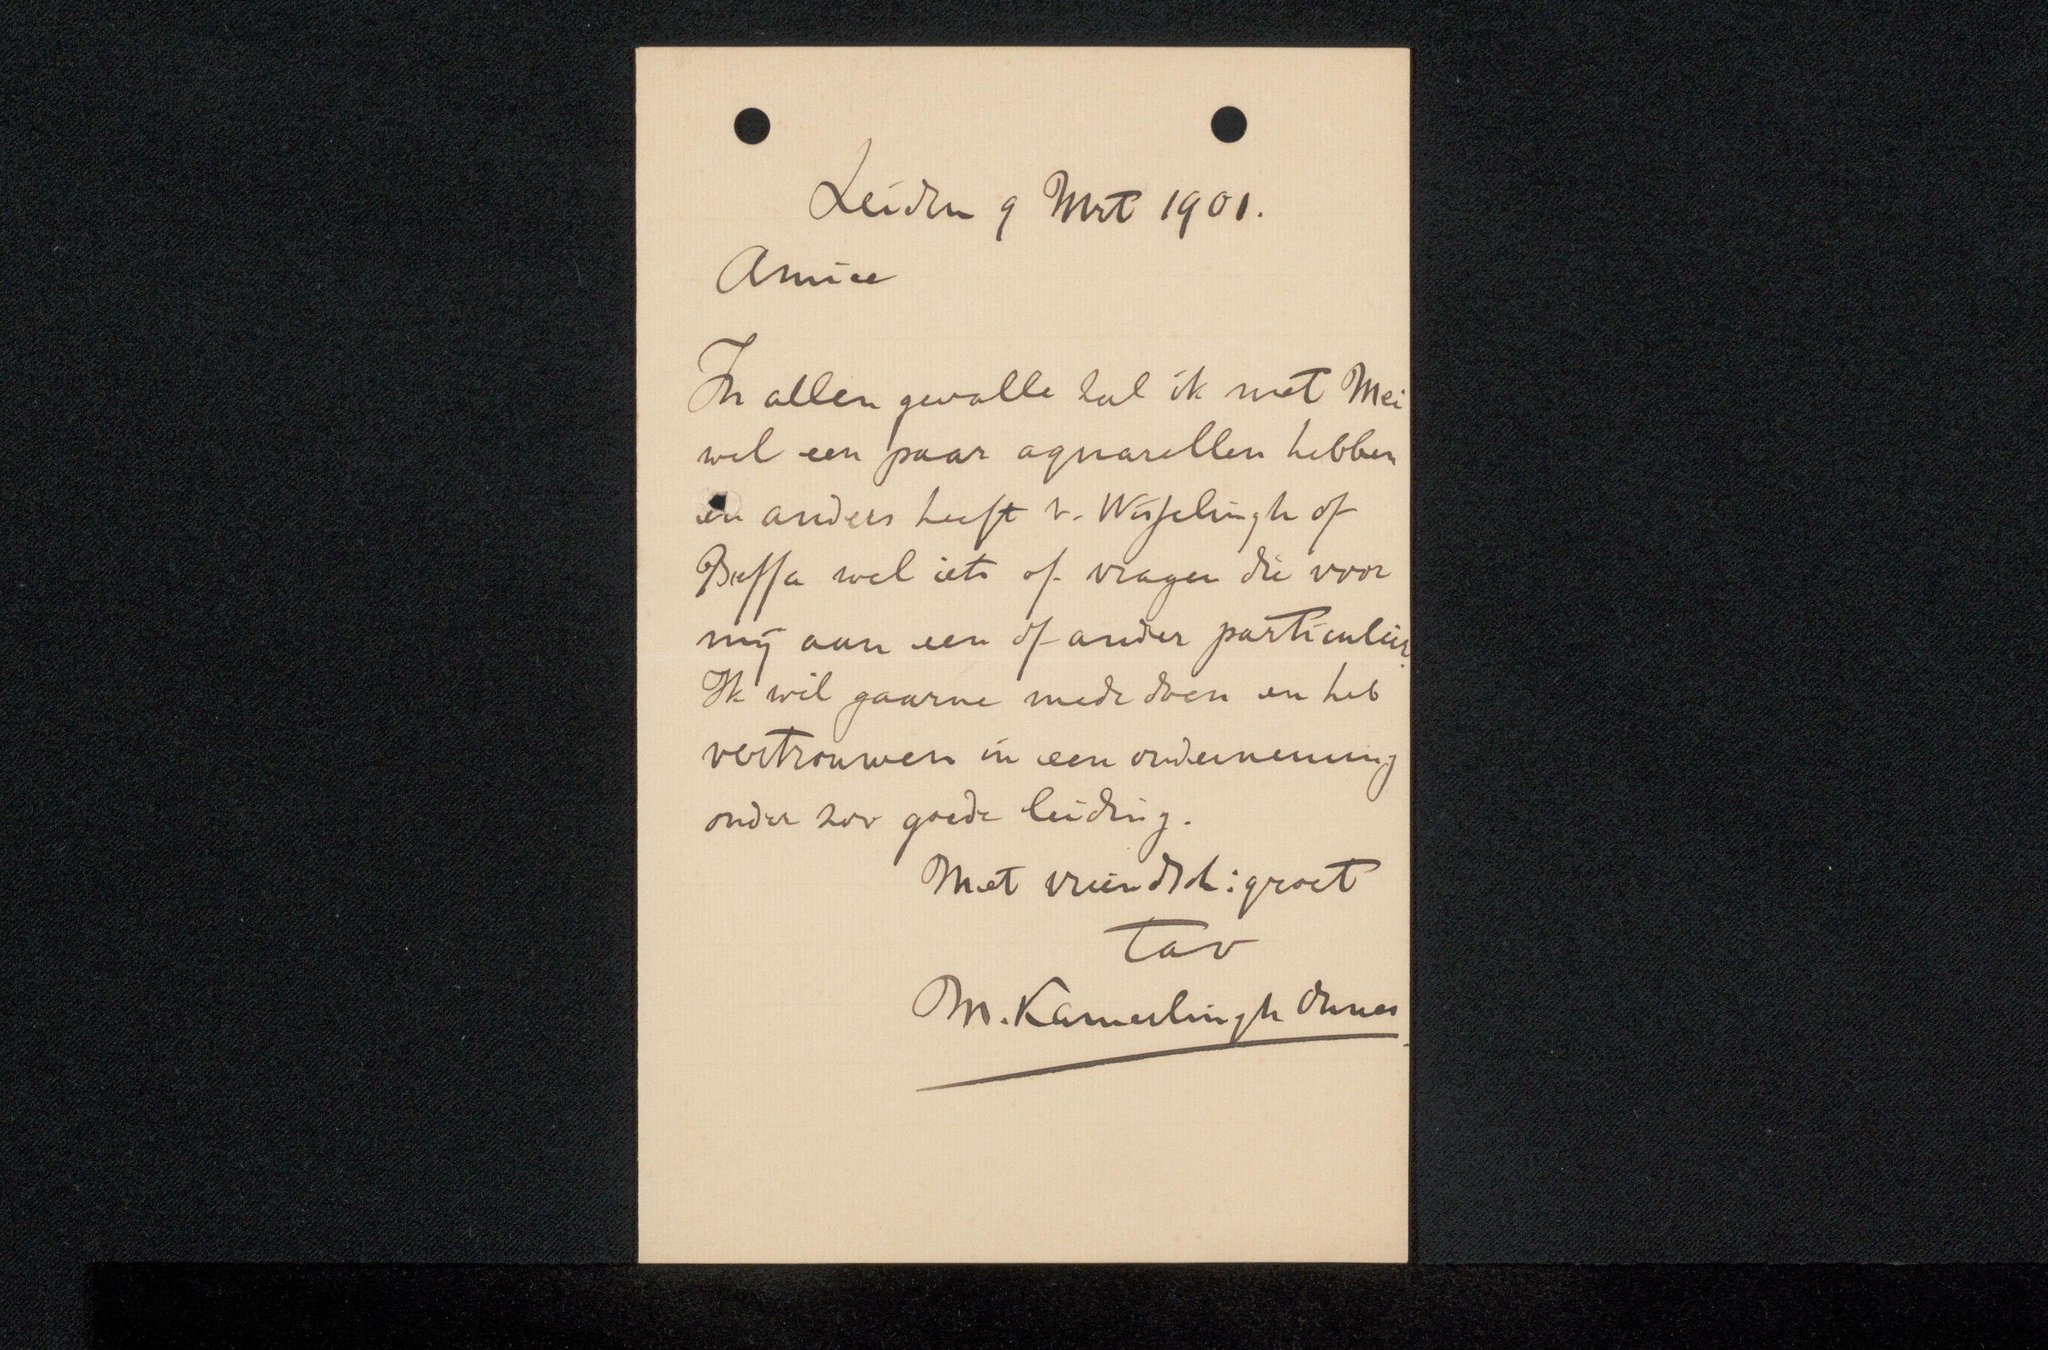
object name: letter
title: Brief aan Philip Zilcken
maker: menso kamerlingh onnes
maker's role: painter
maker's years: 1860-1925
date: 1901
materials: ink, paper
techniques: pen, writing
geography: leiden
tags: the hague, draughtsman, philip zilcken, hotel, hostelry, inn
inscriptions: collector's mark: ‘RPK’